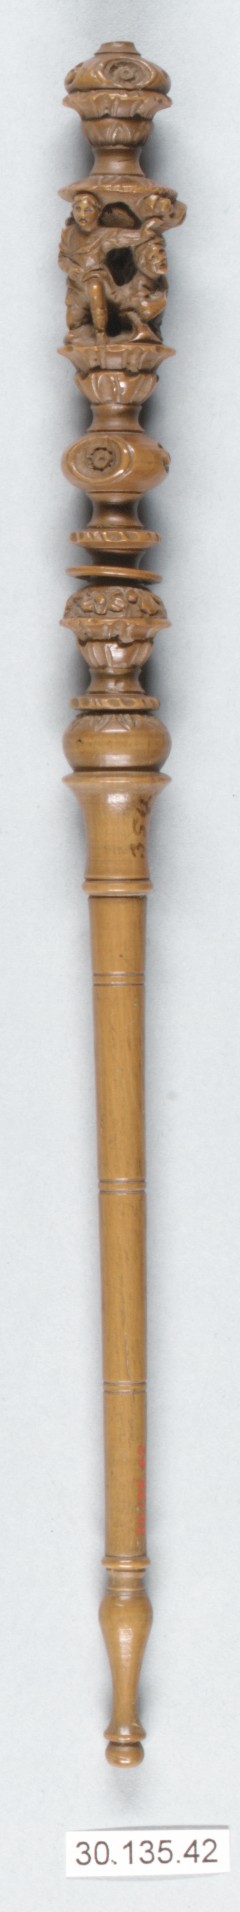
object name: needle sheath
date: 1601-1700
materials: wood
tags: human figures